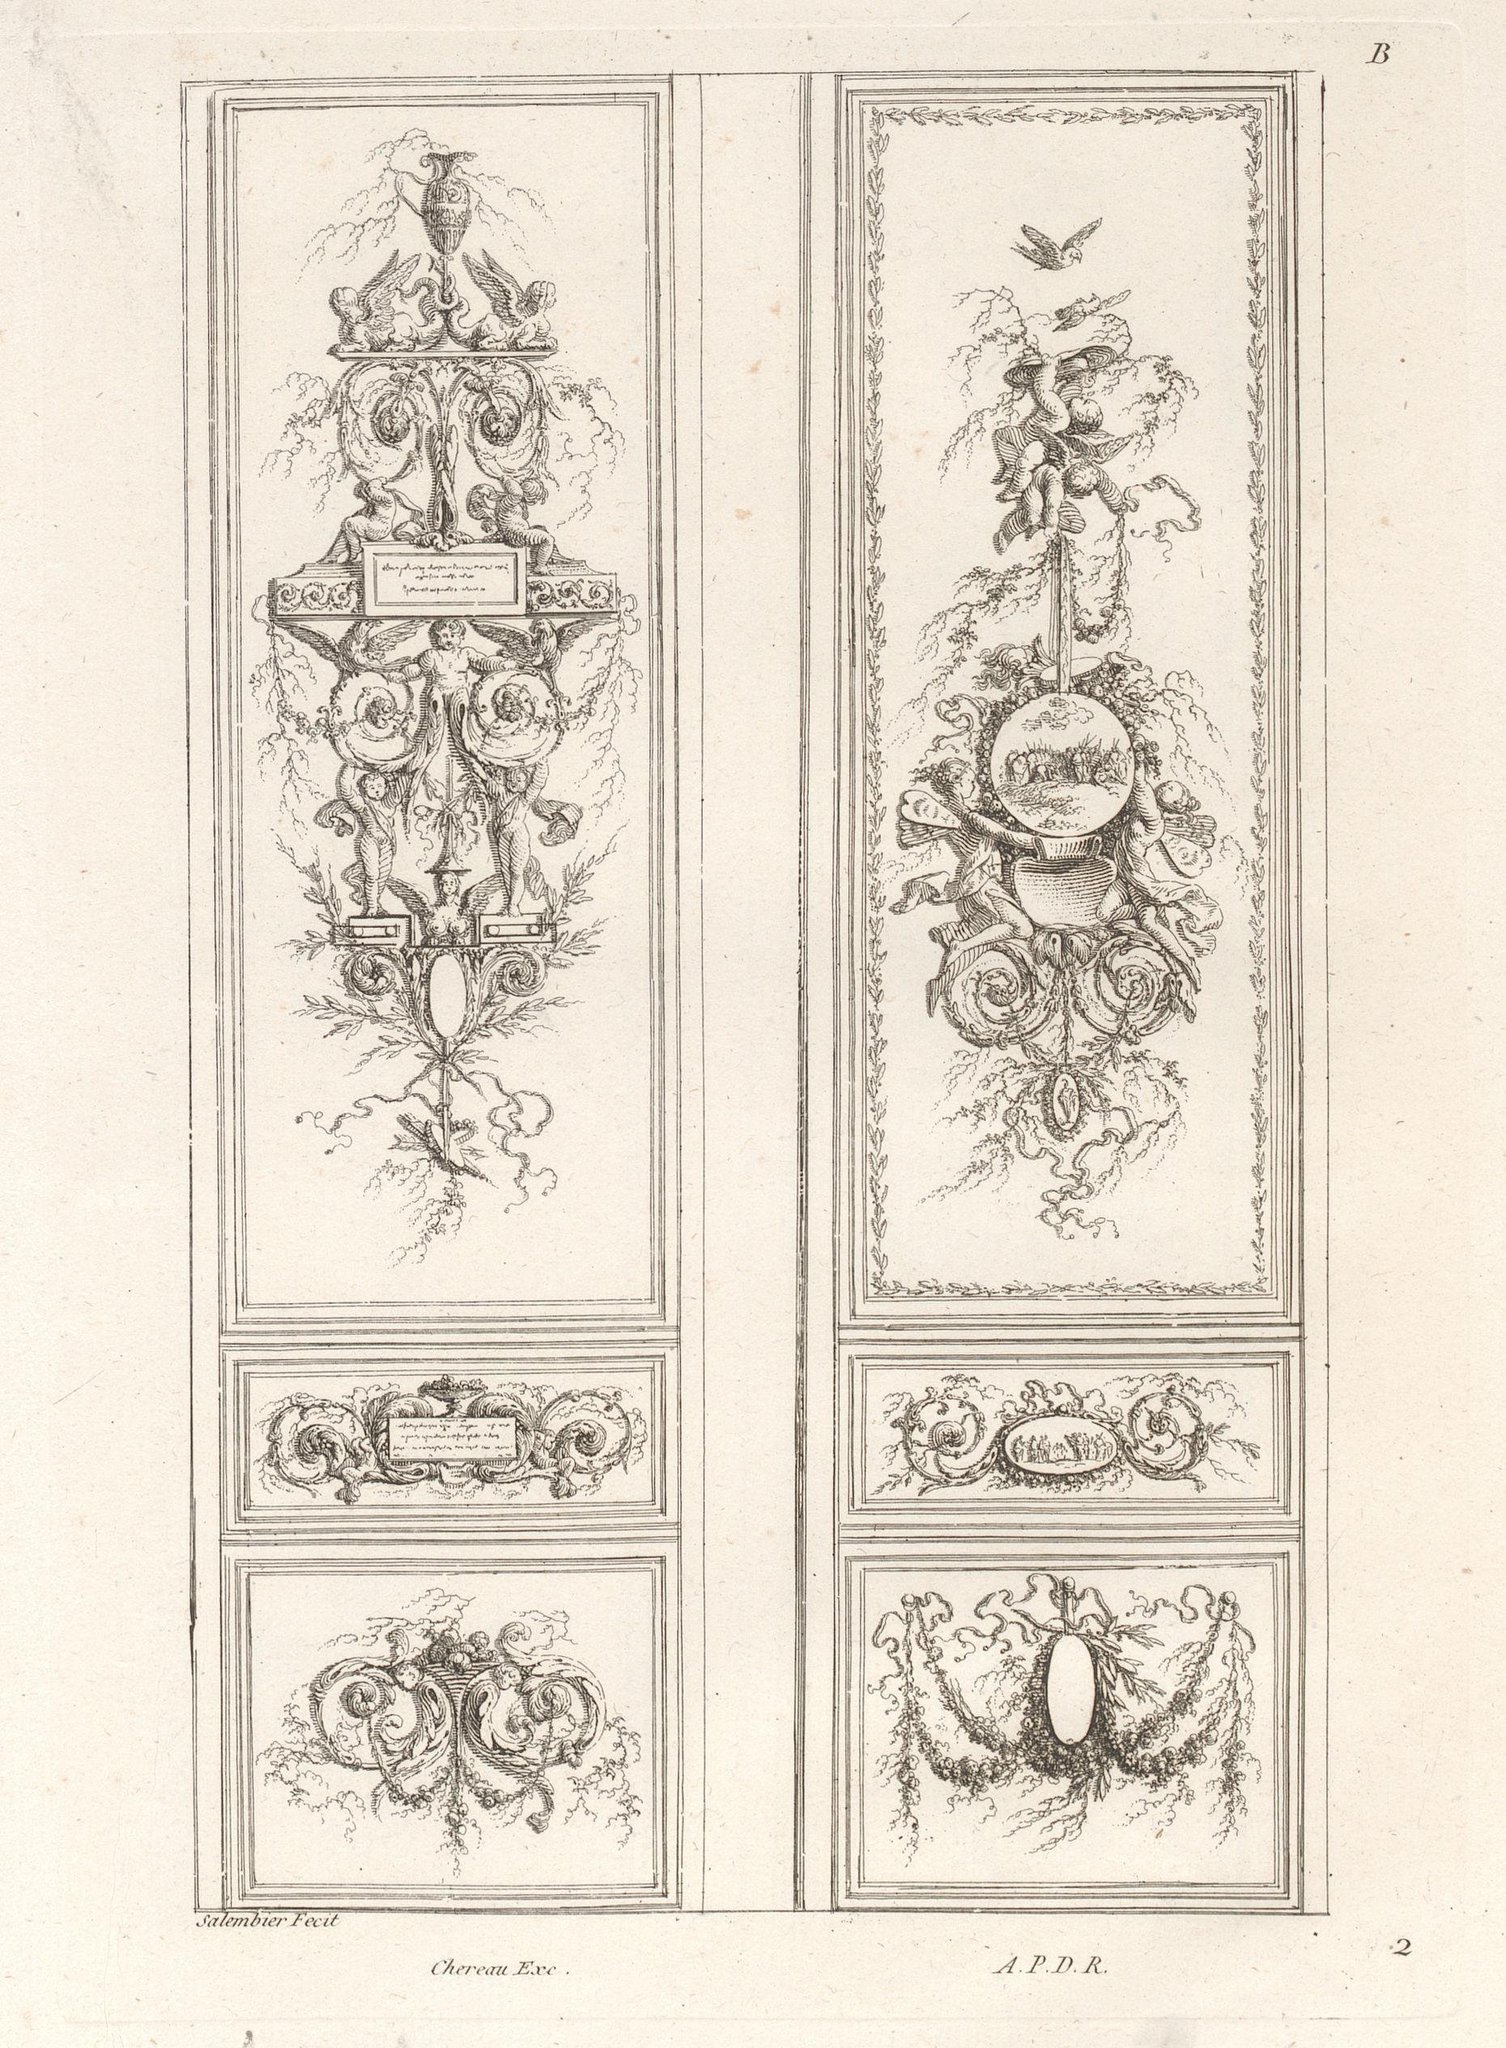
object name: album leaf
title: Arabesken, ontworpen en gegraveerd door Henri Sallembier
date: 1802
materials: paper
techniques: etching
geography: paris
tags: sphinx (lion/woman); 'sfinge' (ripa), ornament ~ arabesque, cupids: 'amores', 'amoretti', 'putti', ornament derived from plant forms, doves, pigeons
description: Doordat dit album bestaat uit meerdere, deels eerder uitgegeven prentreeksen, is de datering niet consequent. Het geheel is op de titelpagina gedateerd op 1802. Deze reeks is niet afzonderlijk gedateerd. De serietitel voor het gehele werk is "Recueil d'arabesques, contenant les loges du Vatican". De andere serietitel is de titel van de specifieke reeks binnen het geheel.